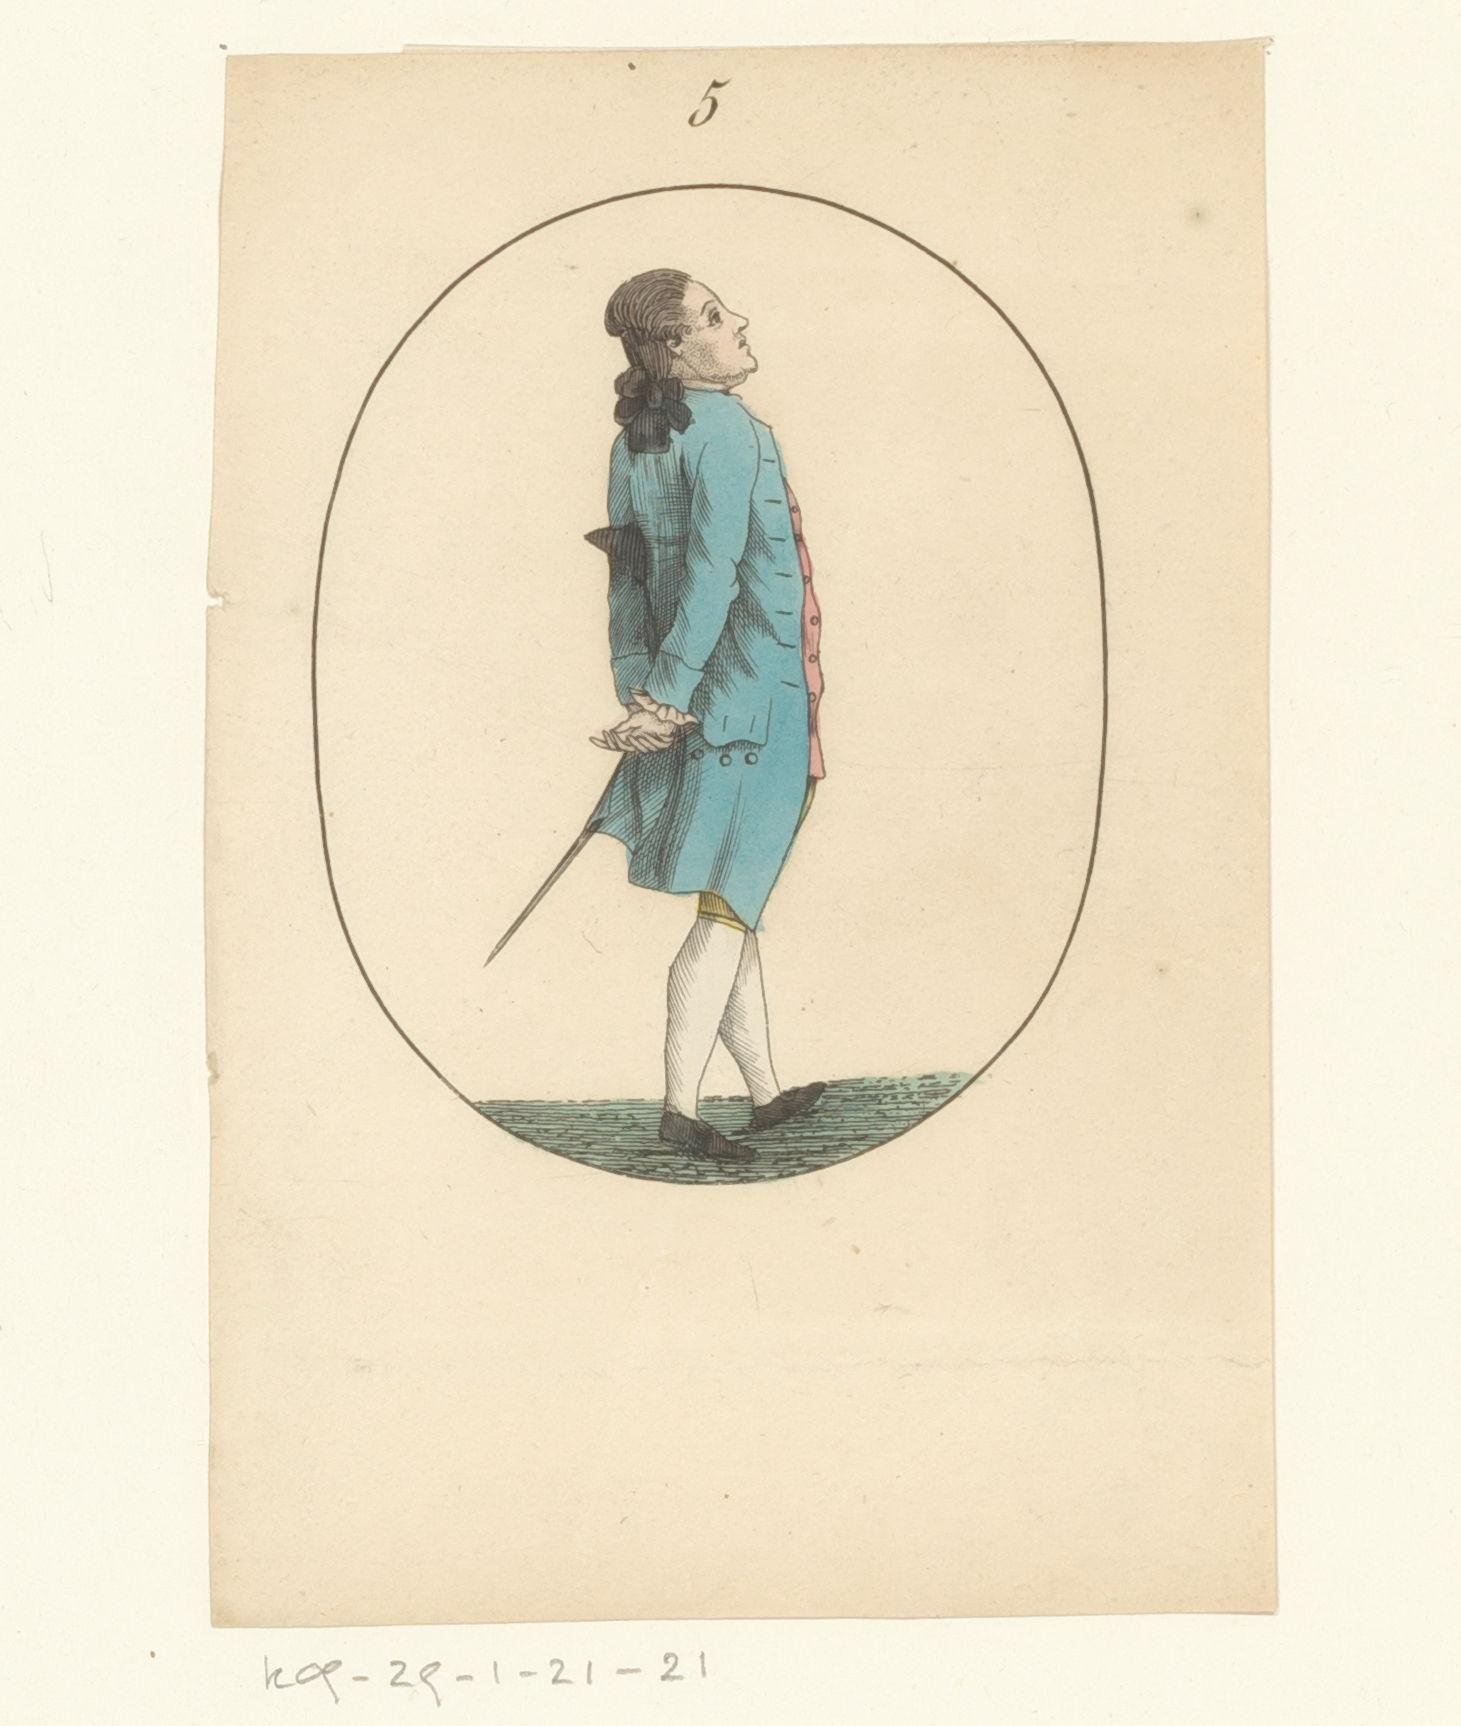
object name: print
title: Man met zijn handen op zijn rug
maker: Anonymous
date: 1750-1849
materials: paper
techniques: etching, hand coloring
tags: head-gear: tricorn, coat, historical costume, contemplation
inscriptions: collector's mark: Lugt 1641, stamp, collector's mark: Lugt 1641a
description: Bovenaan genummerd: 5. Onderwerpsrubrieken binnen de Atlas Zeden en Gewoonten: Zeden en Gewoonten in Engeren Zin, De Kleeding, Kleederdrachten (tijdvakken), De 18de eeuw (de pruikentijd). Mannen en vrouwen.